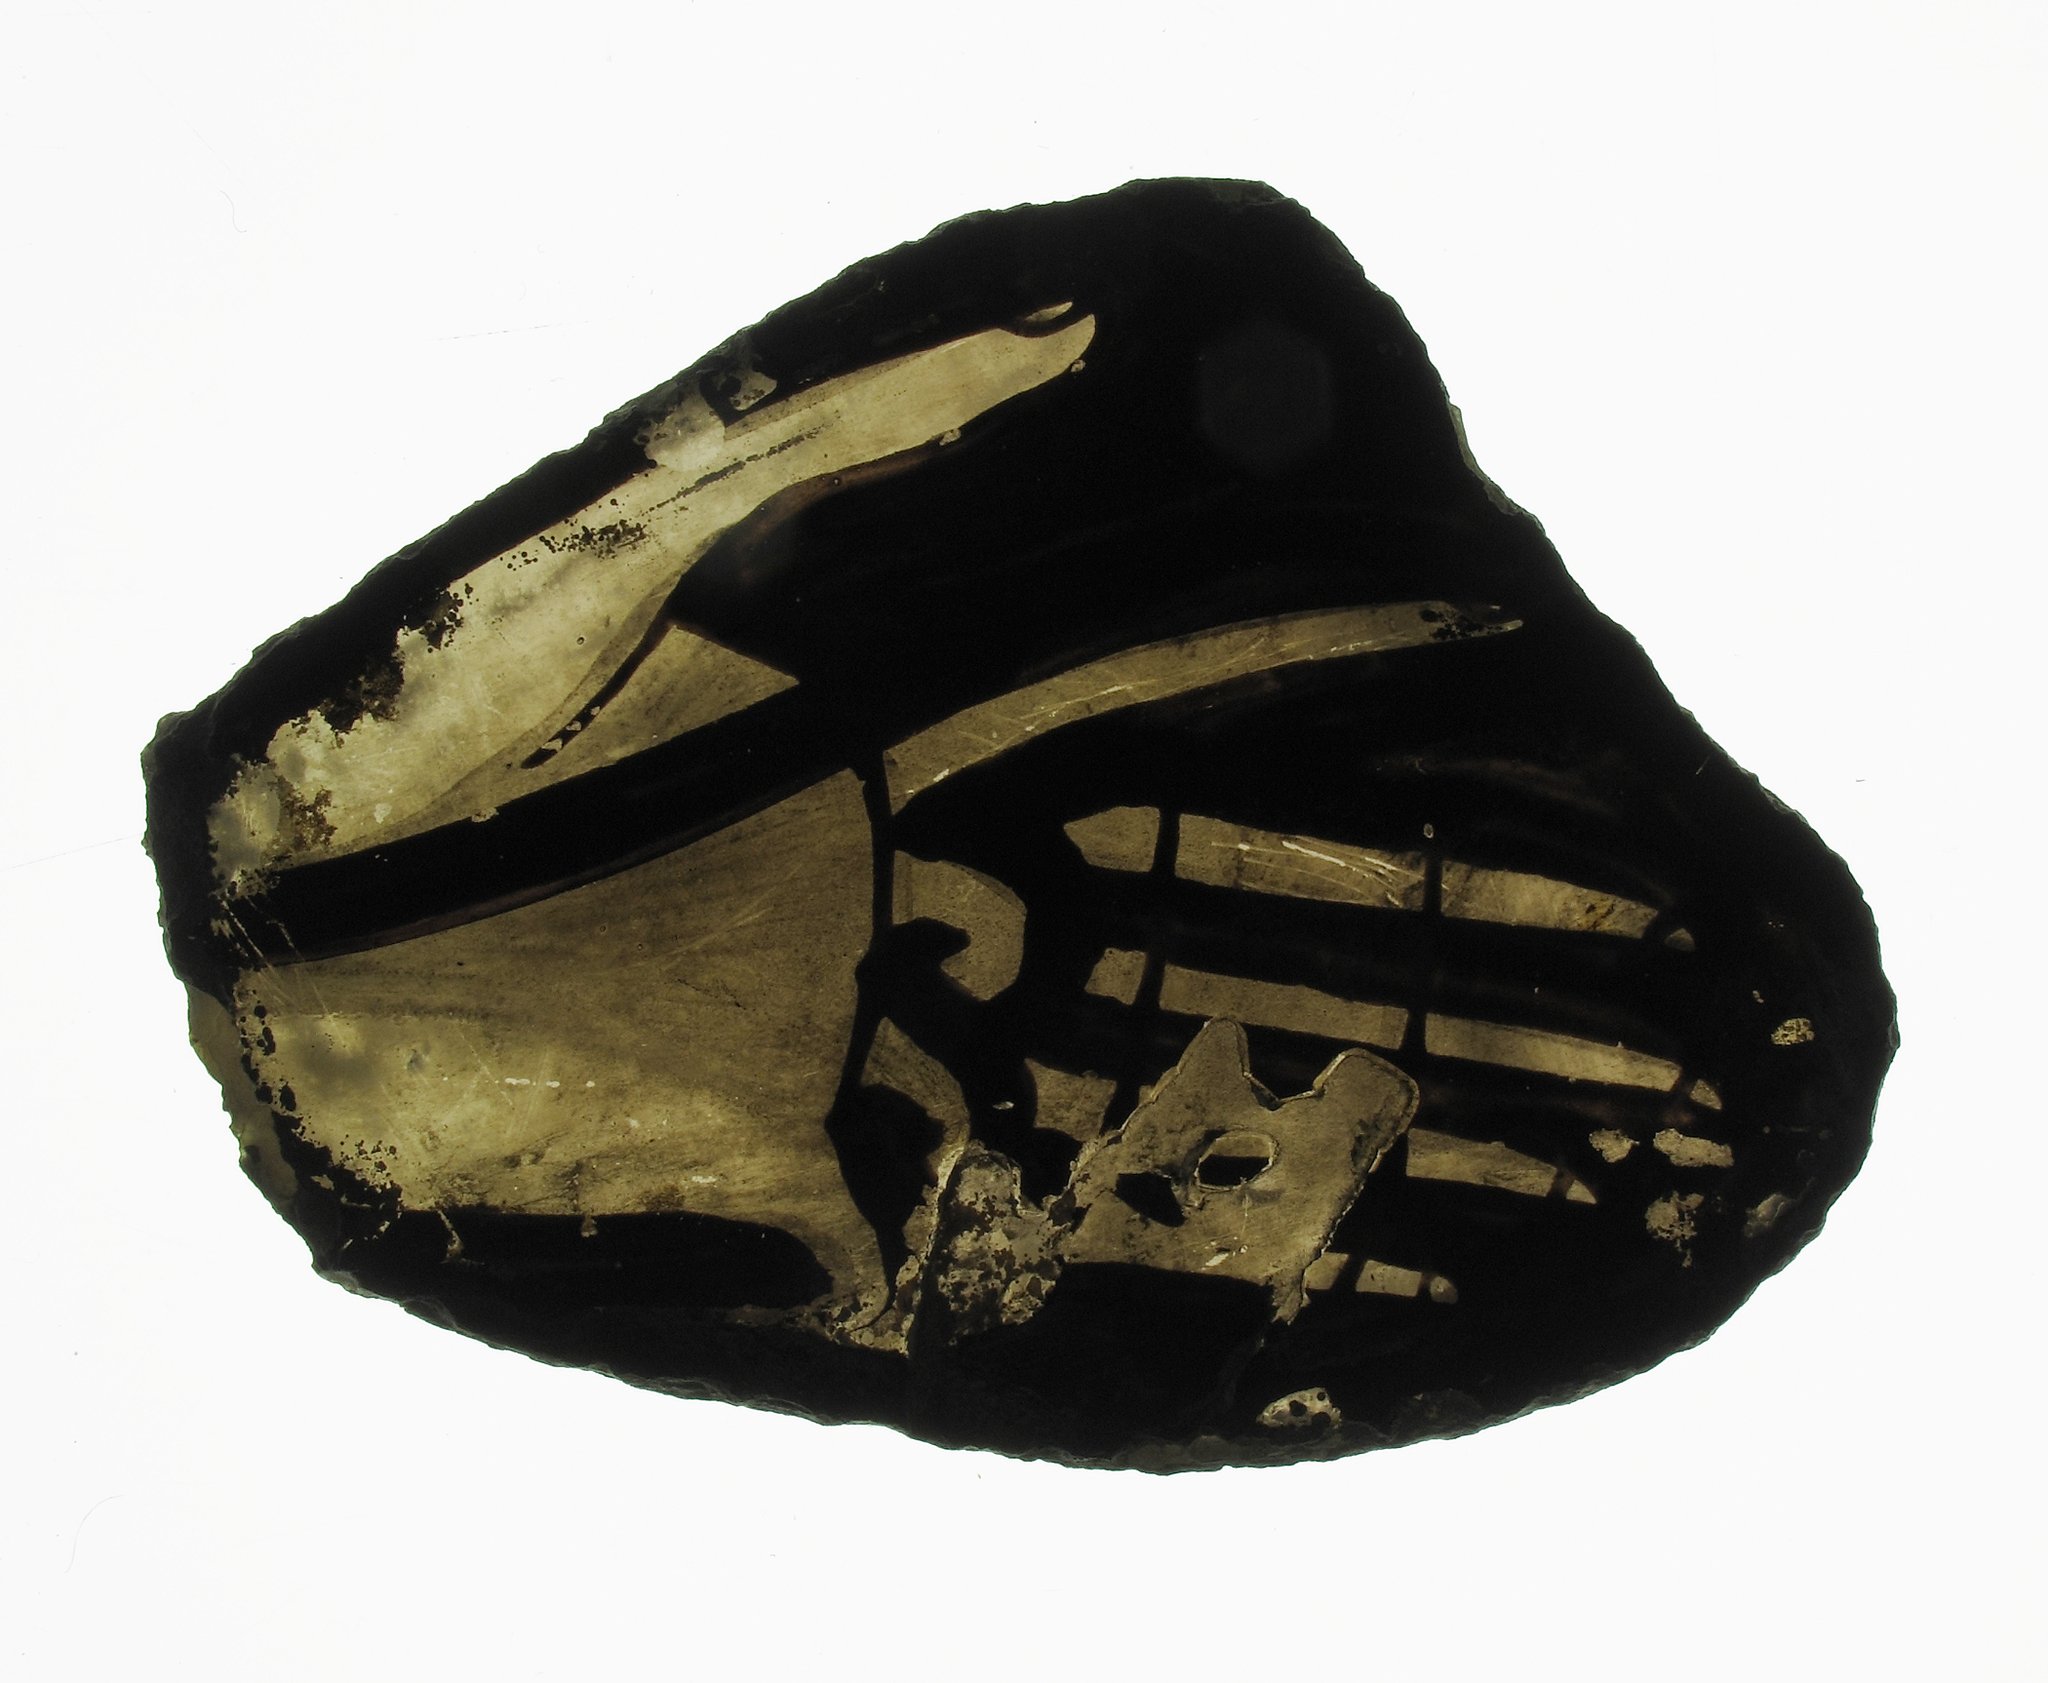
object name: fragment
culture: european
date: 1201-1300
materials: glass, metal, paint